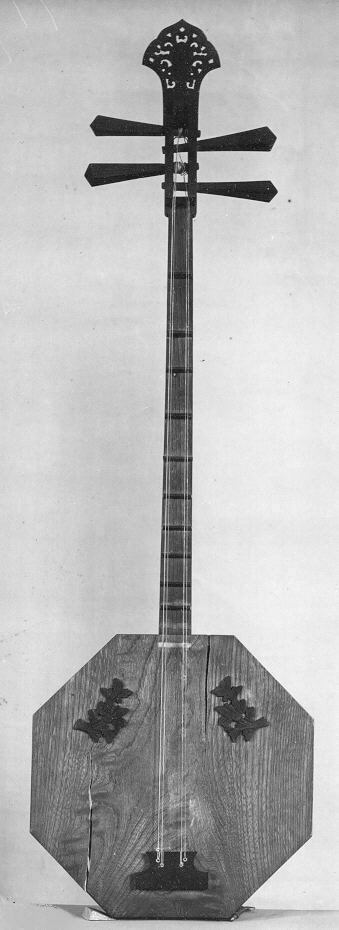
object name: genkin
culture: japanese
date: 1801-1900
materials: wood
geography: japan